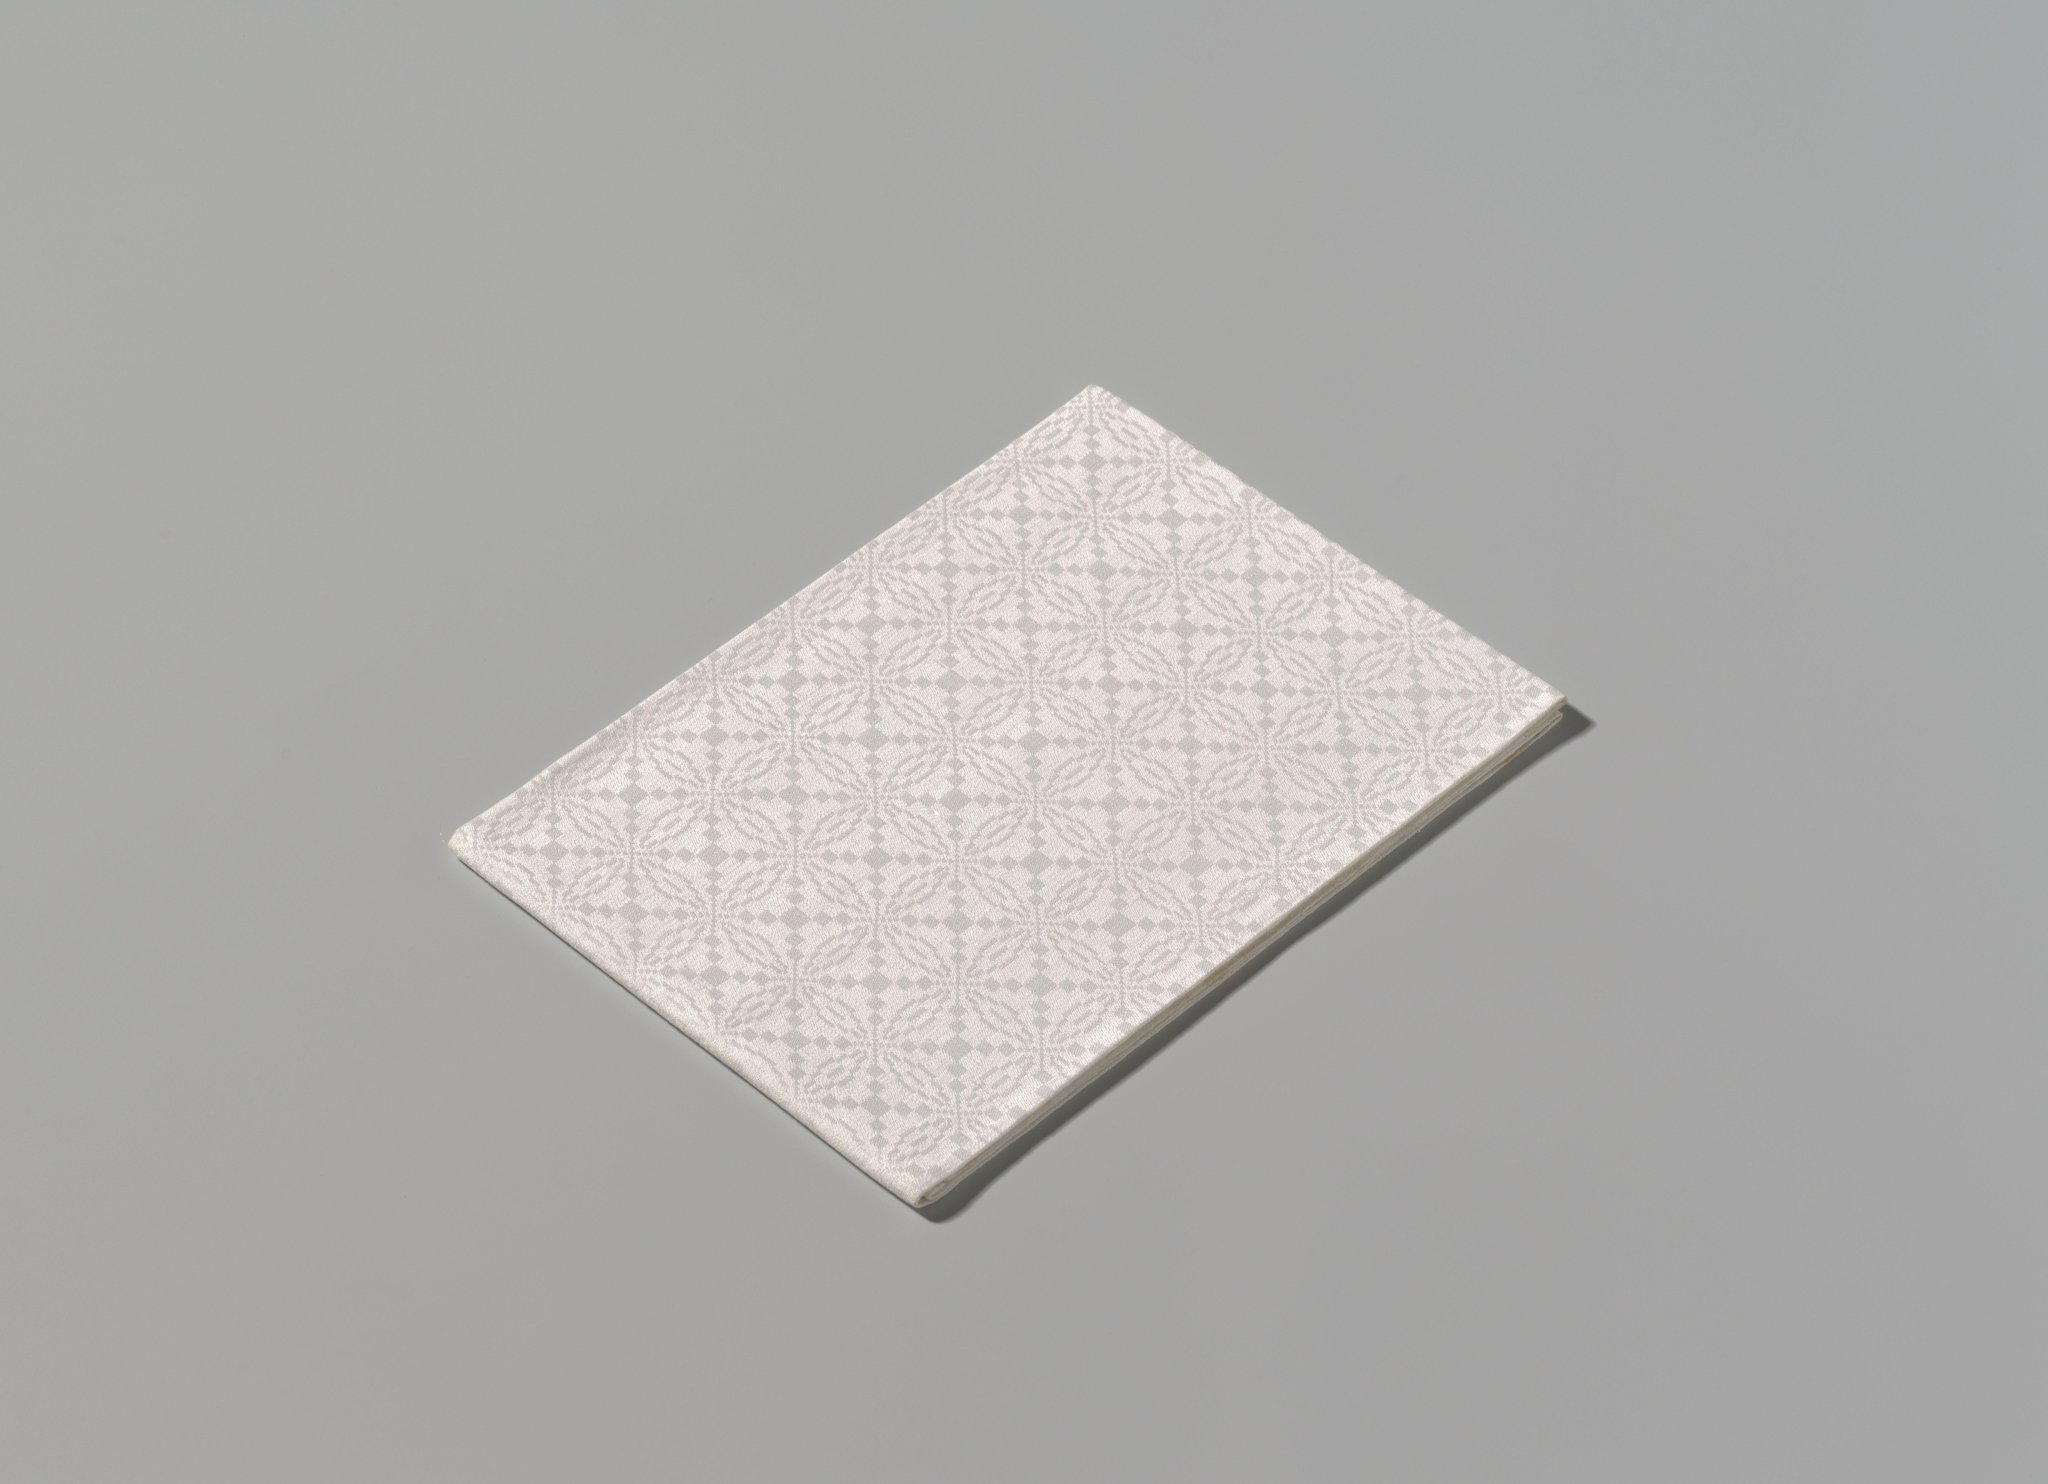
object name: napkin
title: Servet van linnen met pellenpatroon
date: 1620-1660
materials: linen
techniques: peeled fabric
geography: northern netherlands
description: Wit linnen servet met een pellen patroon. Merk AVR HB.